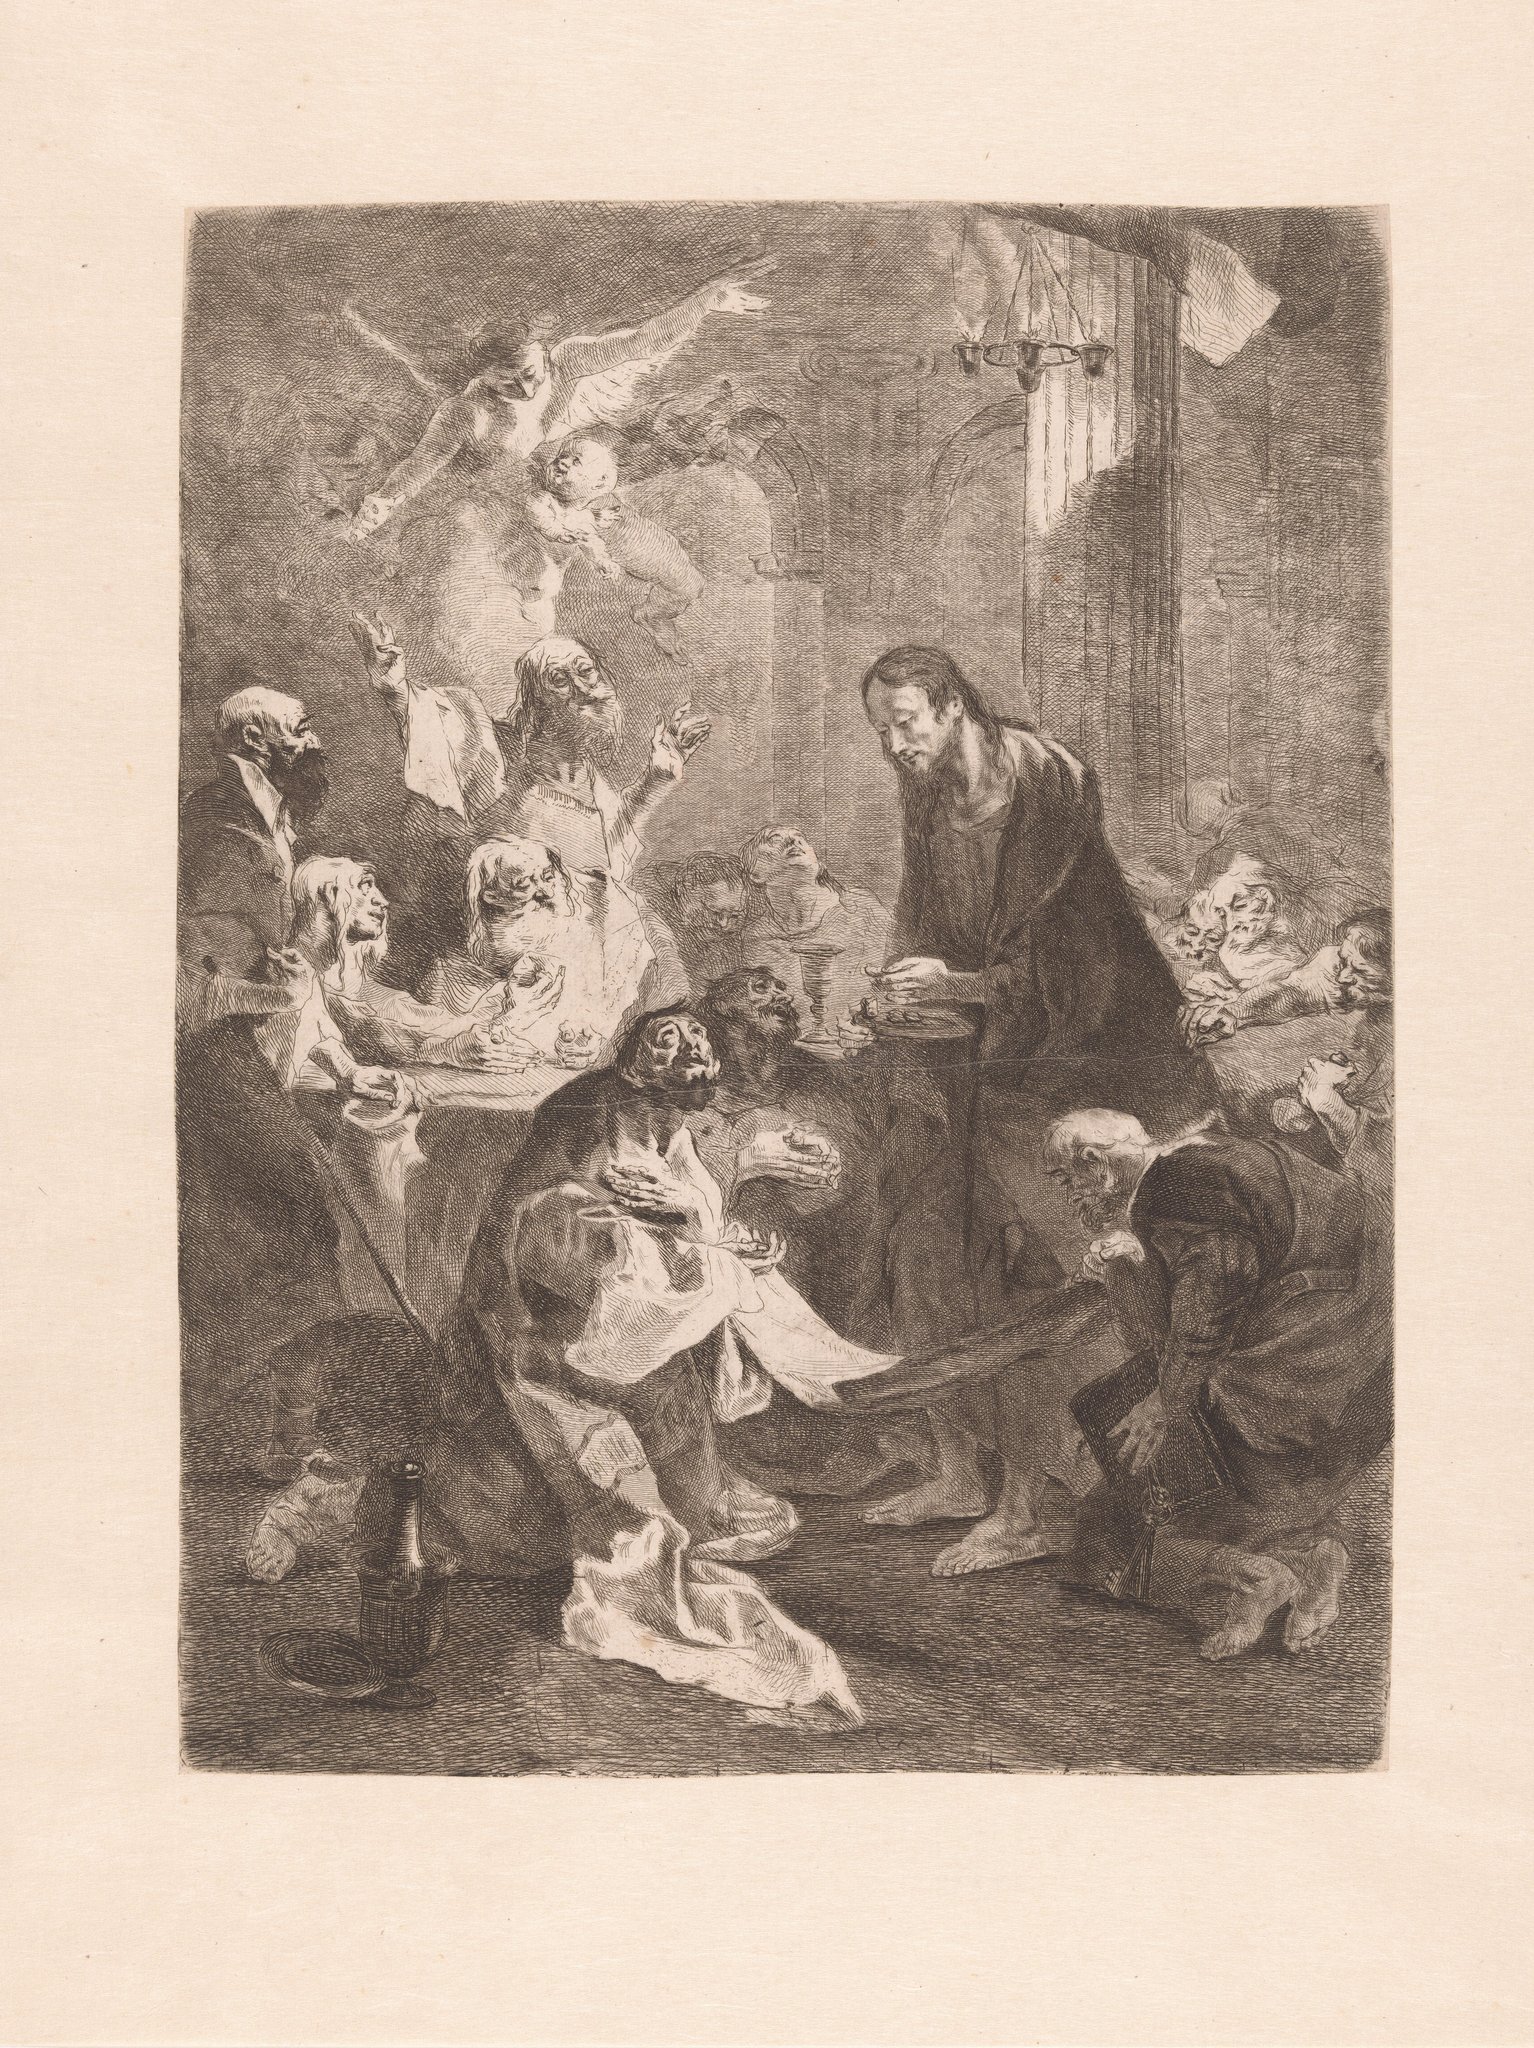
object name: print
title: Communie der apostelen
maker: franz anton maulbertsch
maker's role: print maker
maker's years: 1724-1796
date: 1765-1770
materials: paper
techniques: drypoint, etching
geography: germany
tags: communion of the apostles: christ giving bread (host) and/or wine to the (standing) apostles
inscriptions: collector's mark: Lugt 2228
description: Christus geeft de apostelen de heilige communie. In een tempelruimte staat Jezus voor een tafel waaraan de apostelen zitten. Hij deelt brood uit aan twee knielende apostelen voor hem. Op de tafel de kelk met wijn. Boven de tafel een engel en een cherubijn.